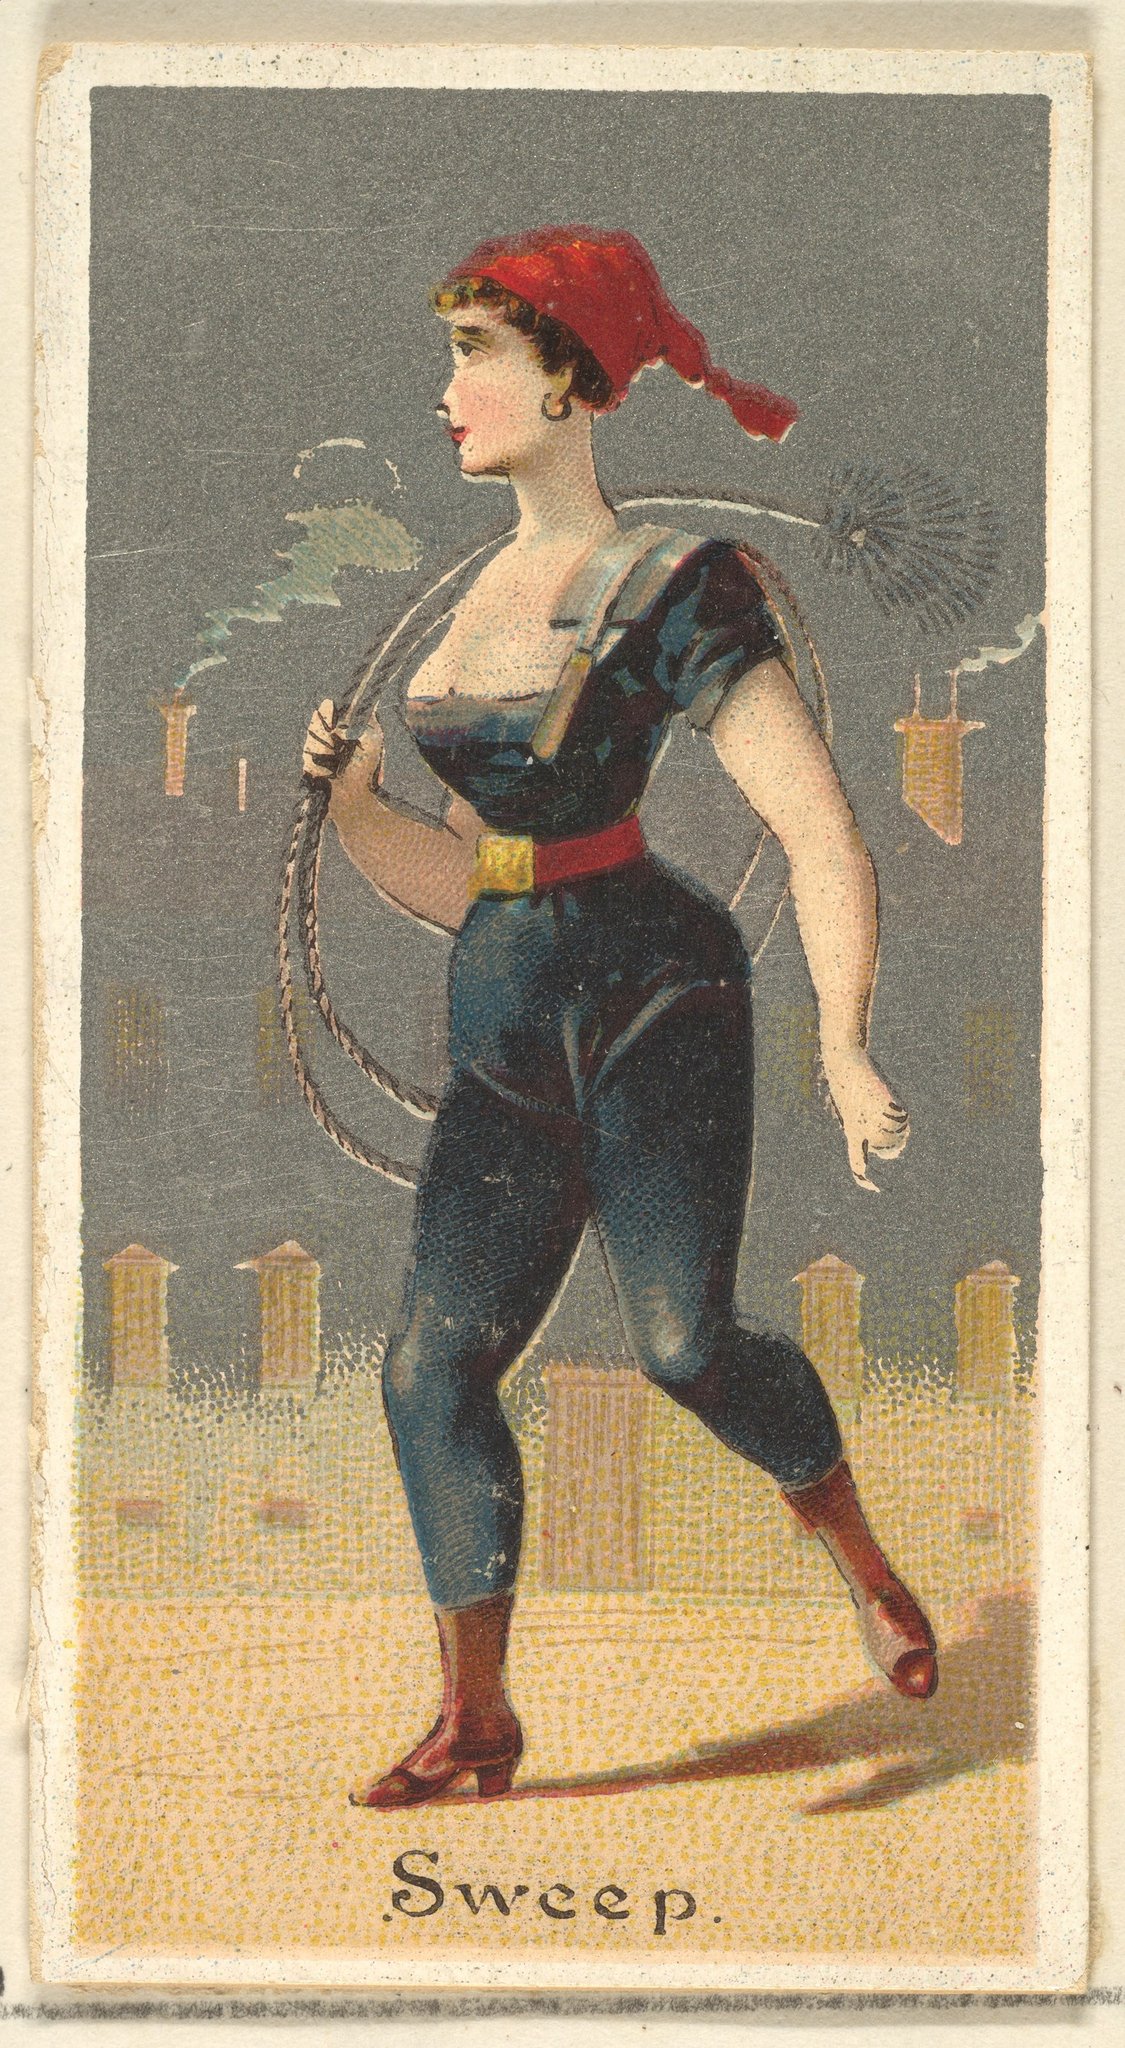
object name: print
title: Sweep, from the Occupations for Women series (N166) for Old Judge and Dogs Head Cigarettes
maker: goodwin & company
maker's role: publisher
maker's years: 1850-1950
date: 1887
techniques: color lithograph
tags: profiles,women